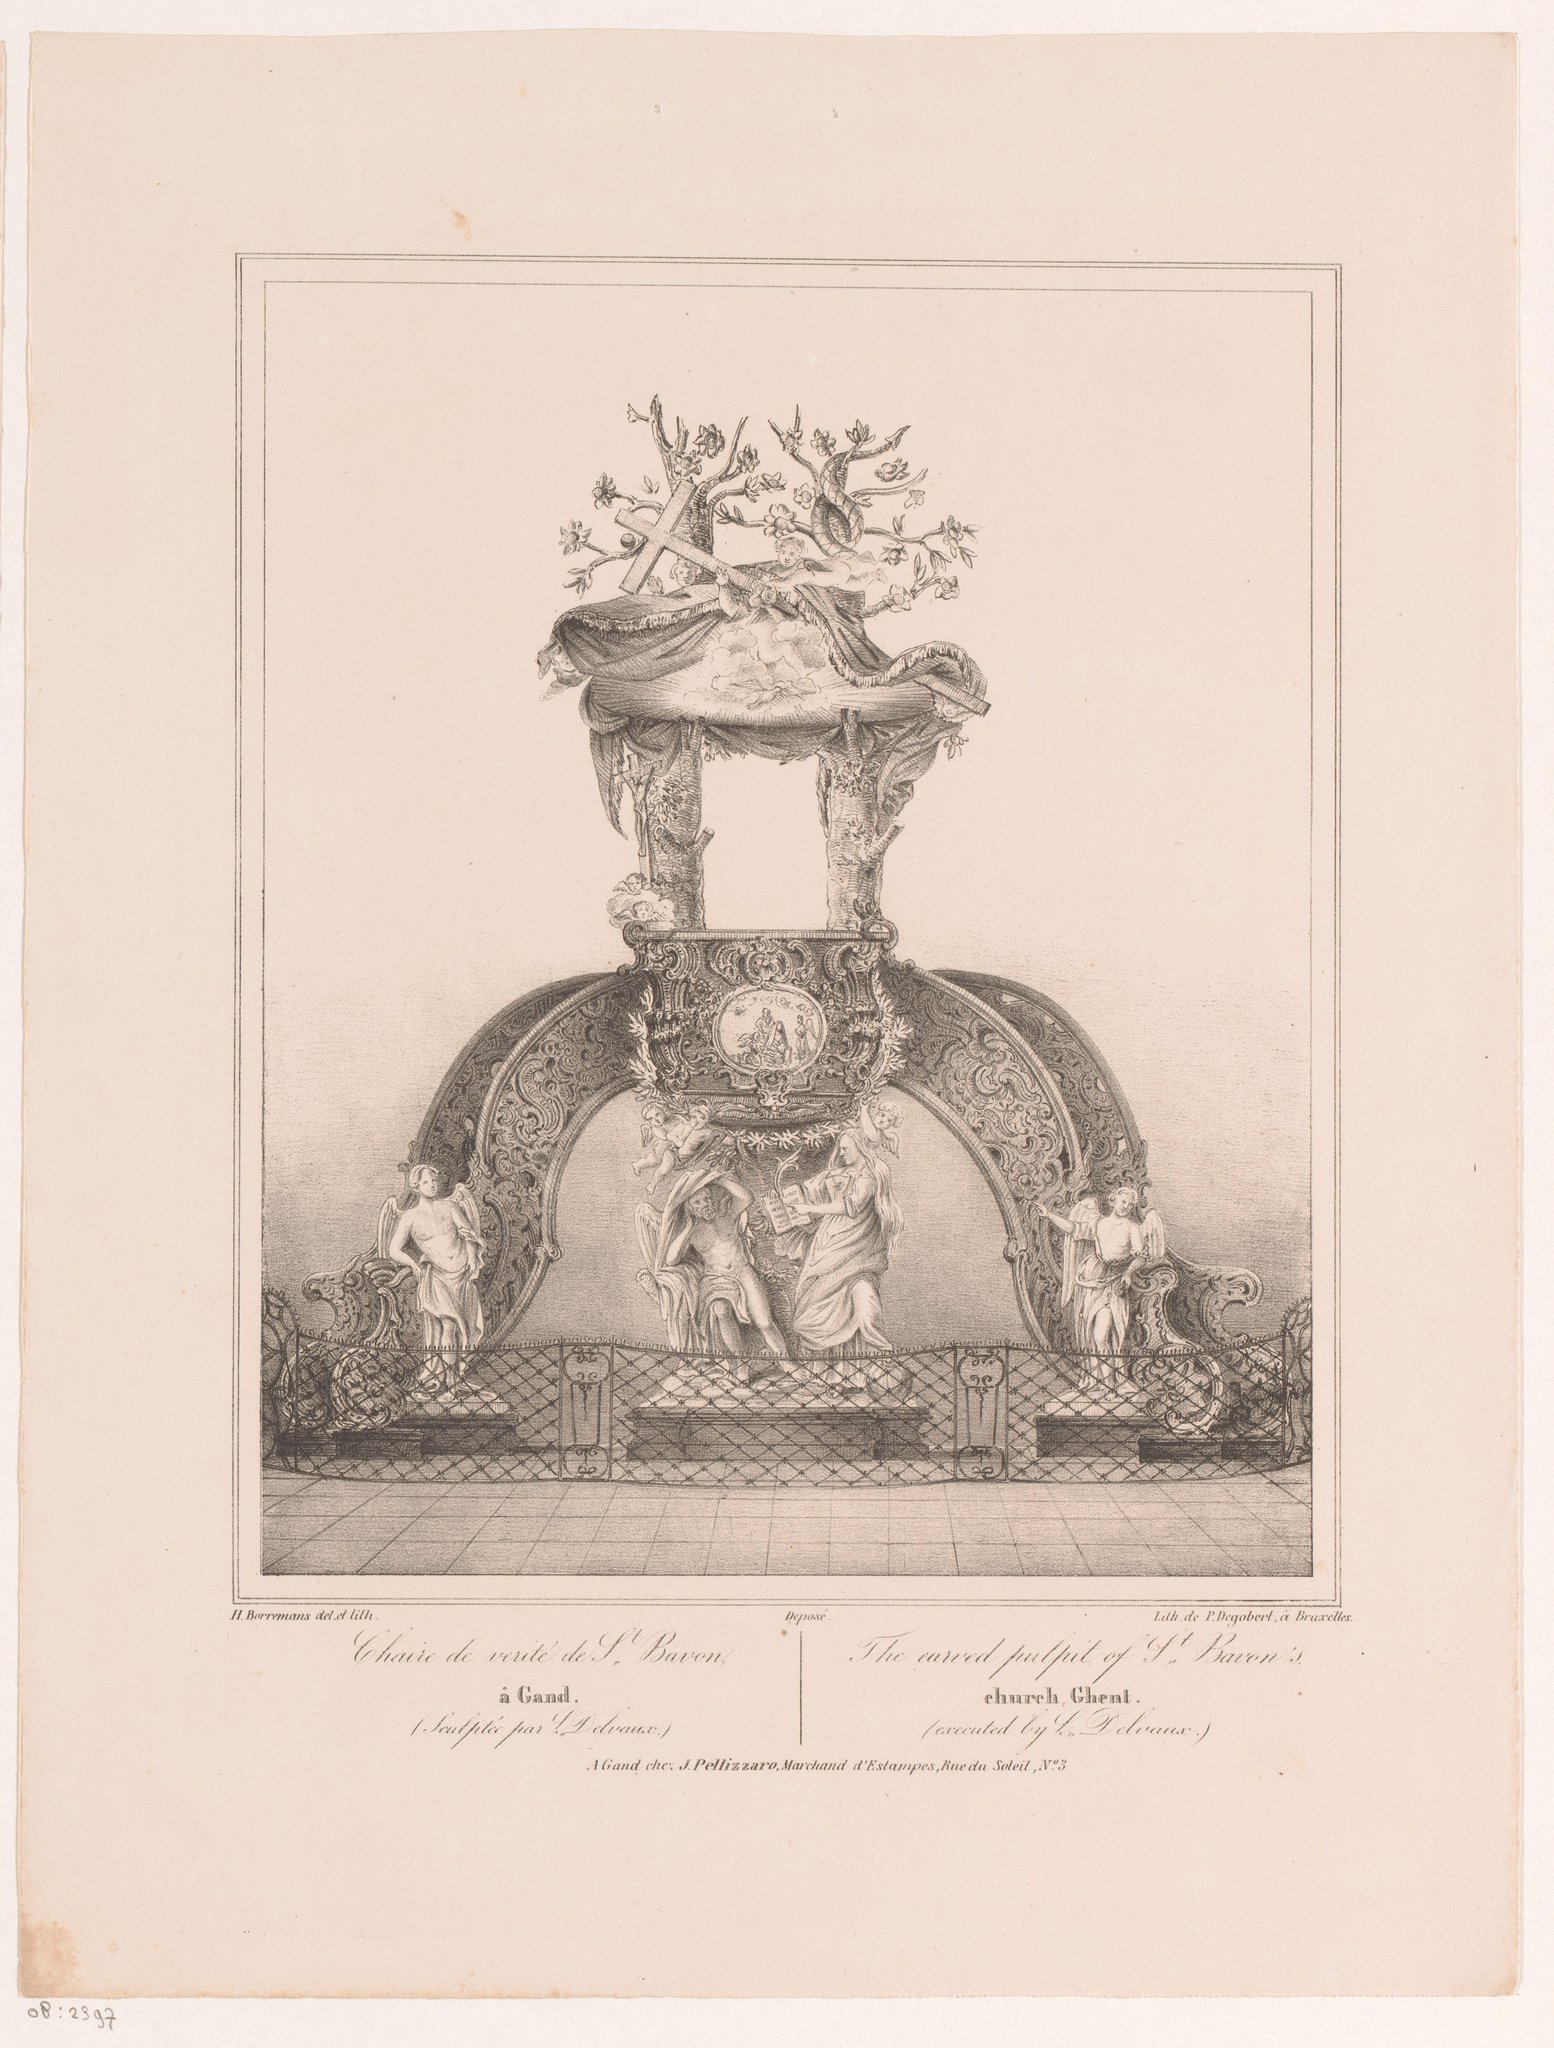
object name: print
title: Chaire de verité de St. Baven, à Gand (sculpté par L. Delvaux) / The carved pulpit of St. Baven's church, Ghent (executed by L. Delvaux)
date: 1822-1844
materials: paper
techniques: lithograph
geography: brussels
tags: pulpit, ambo, chancel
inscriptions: : ‘Déposé’, collector's mark: Lugt 2228